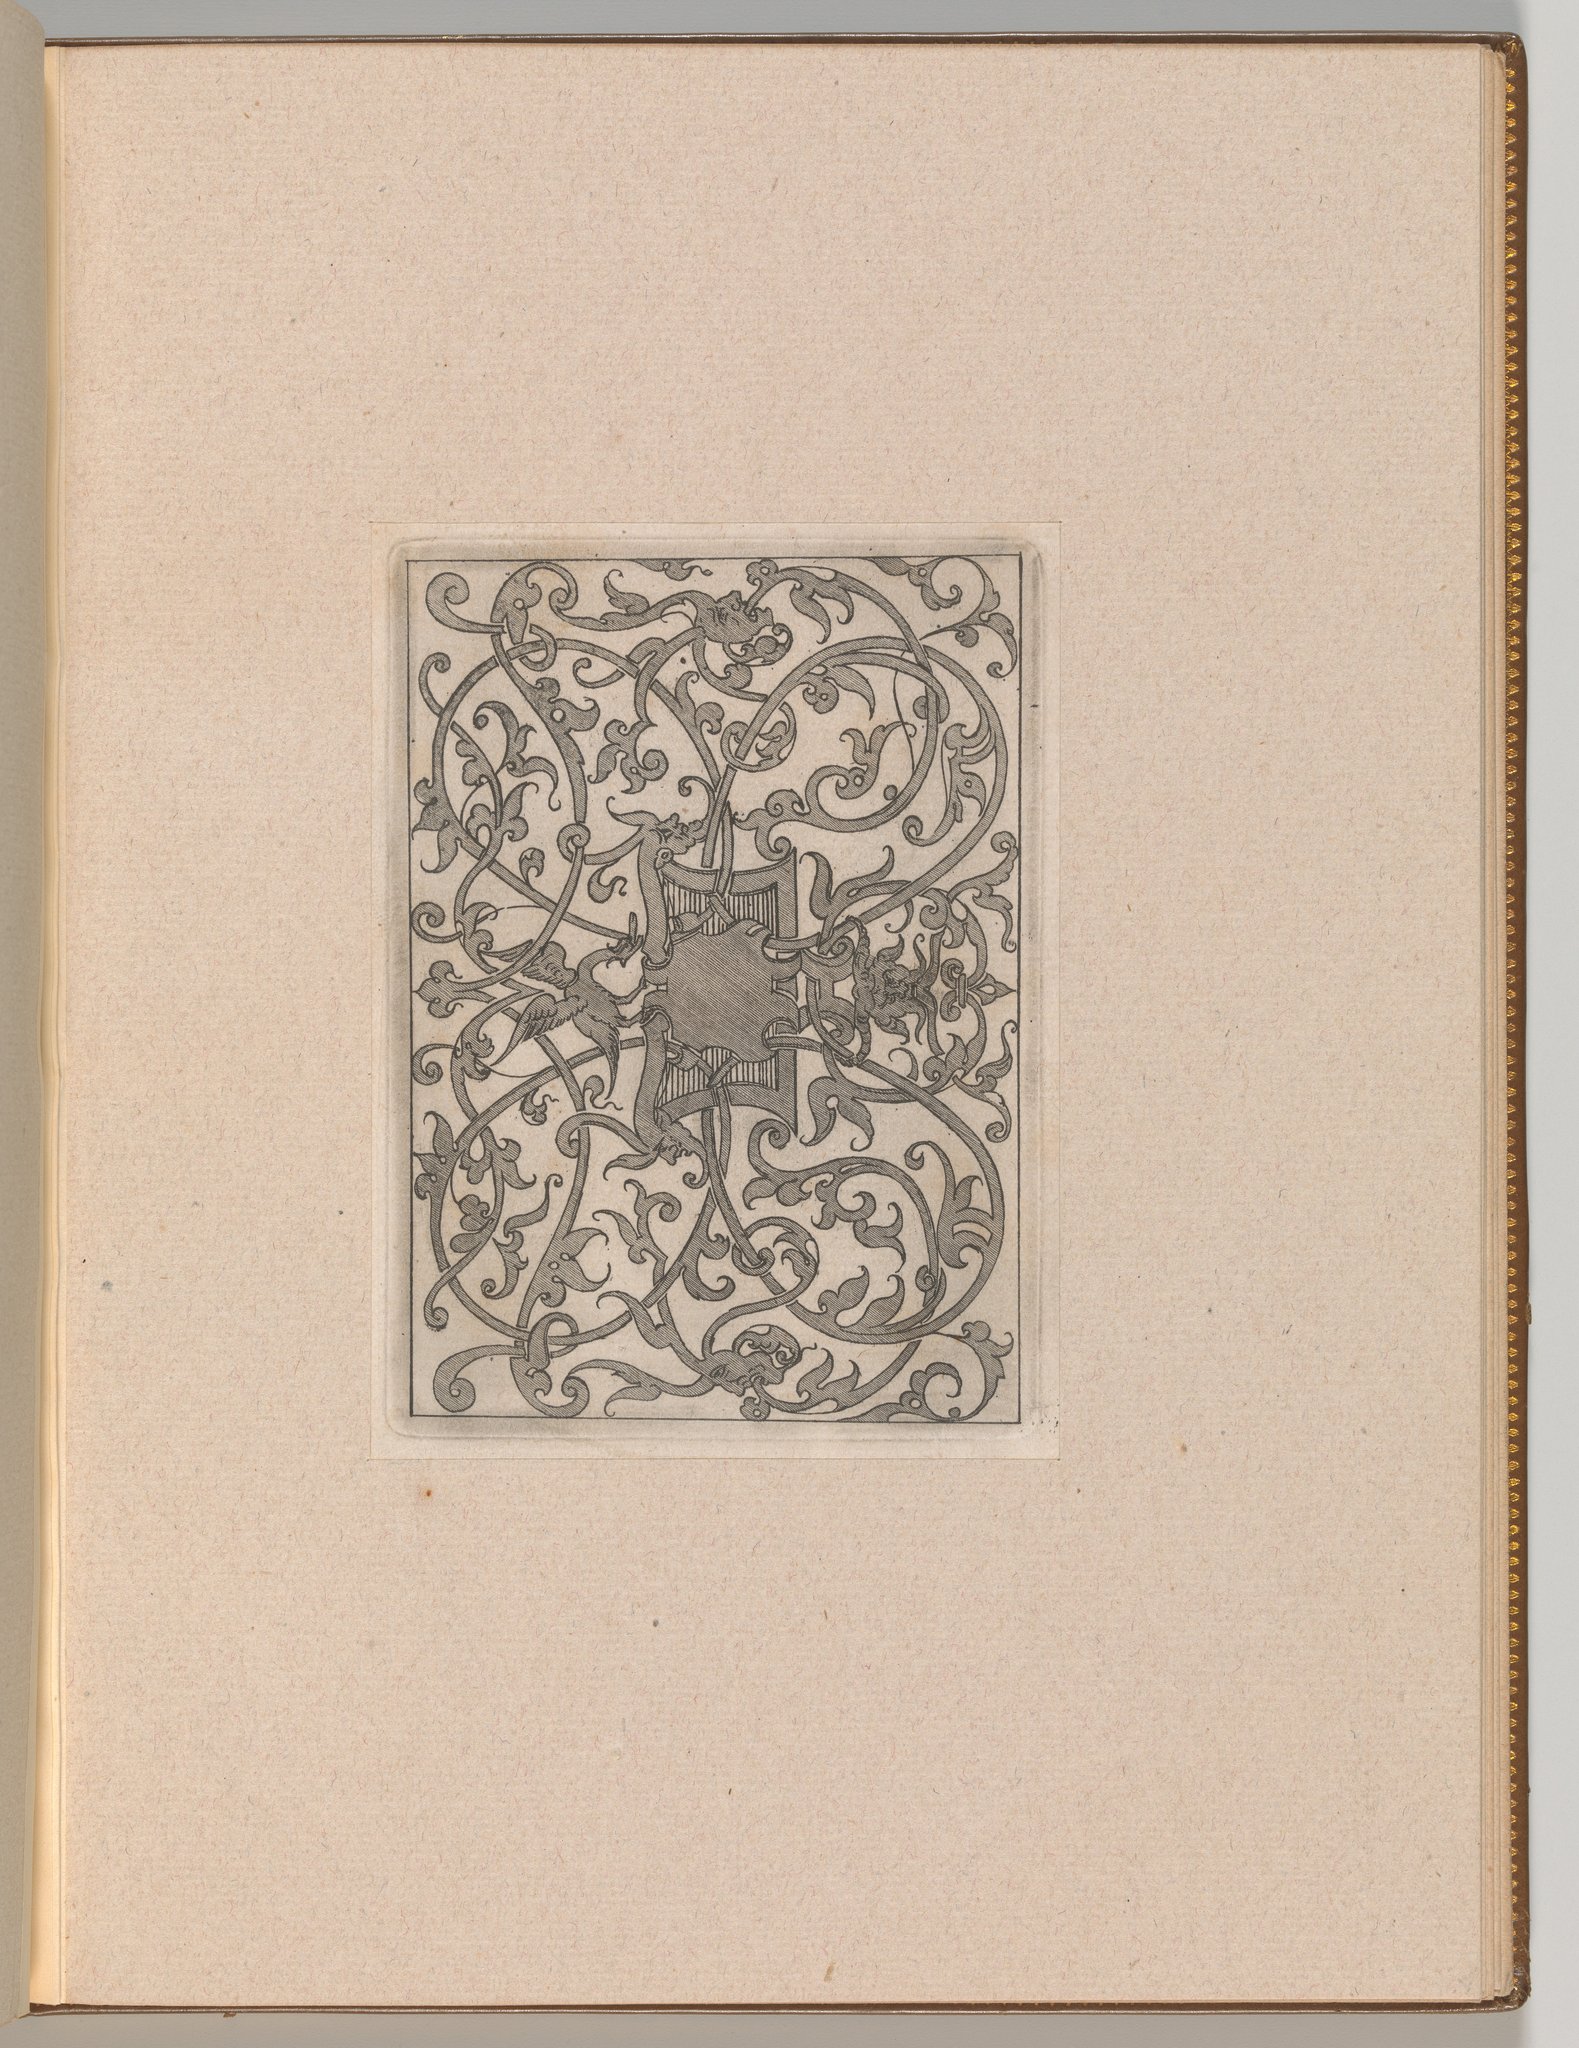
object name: album print ornament architecture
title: Copies after the 'Livre contenant passement de moresques' (plate 4)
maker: jacques androuet du cerceau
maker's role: artist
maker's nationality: french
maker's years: 1510-1585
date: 1801-1900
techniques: etching